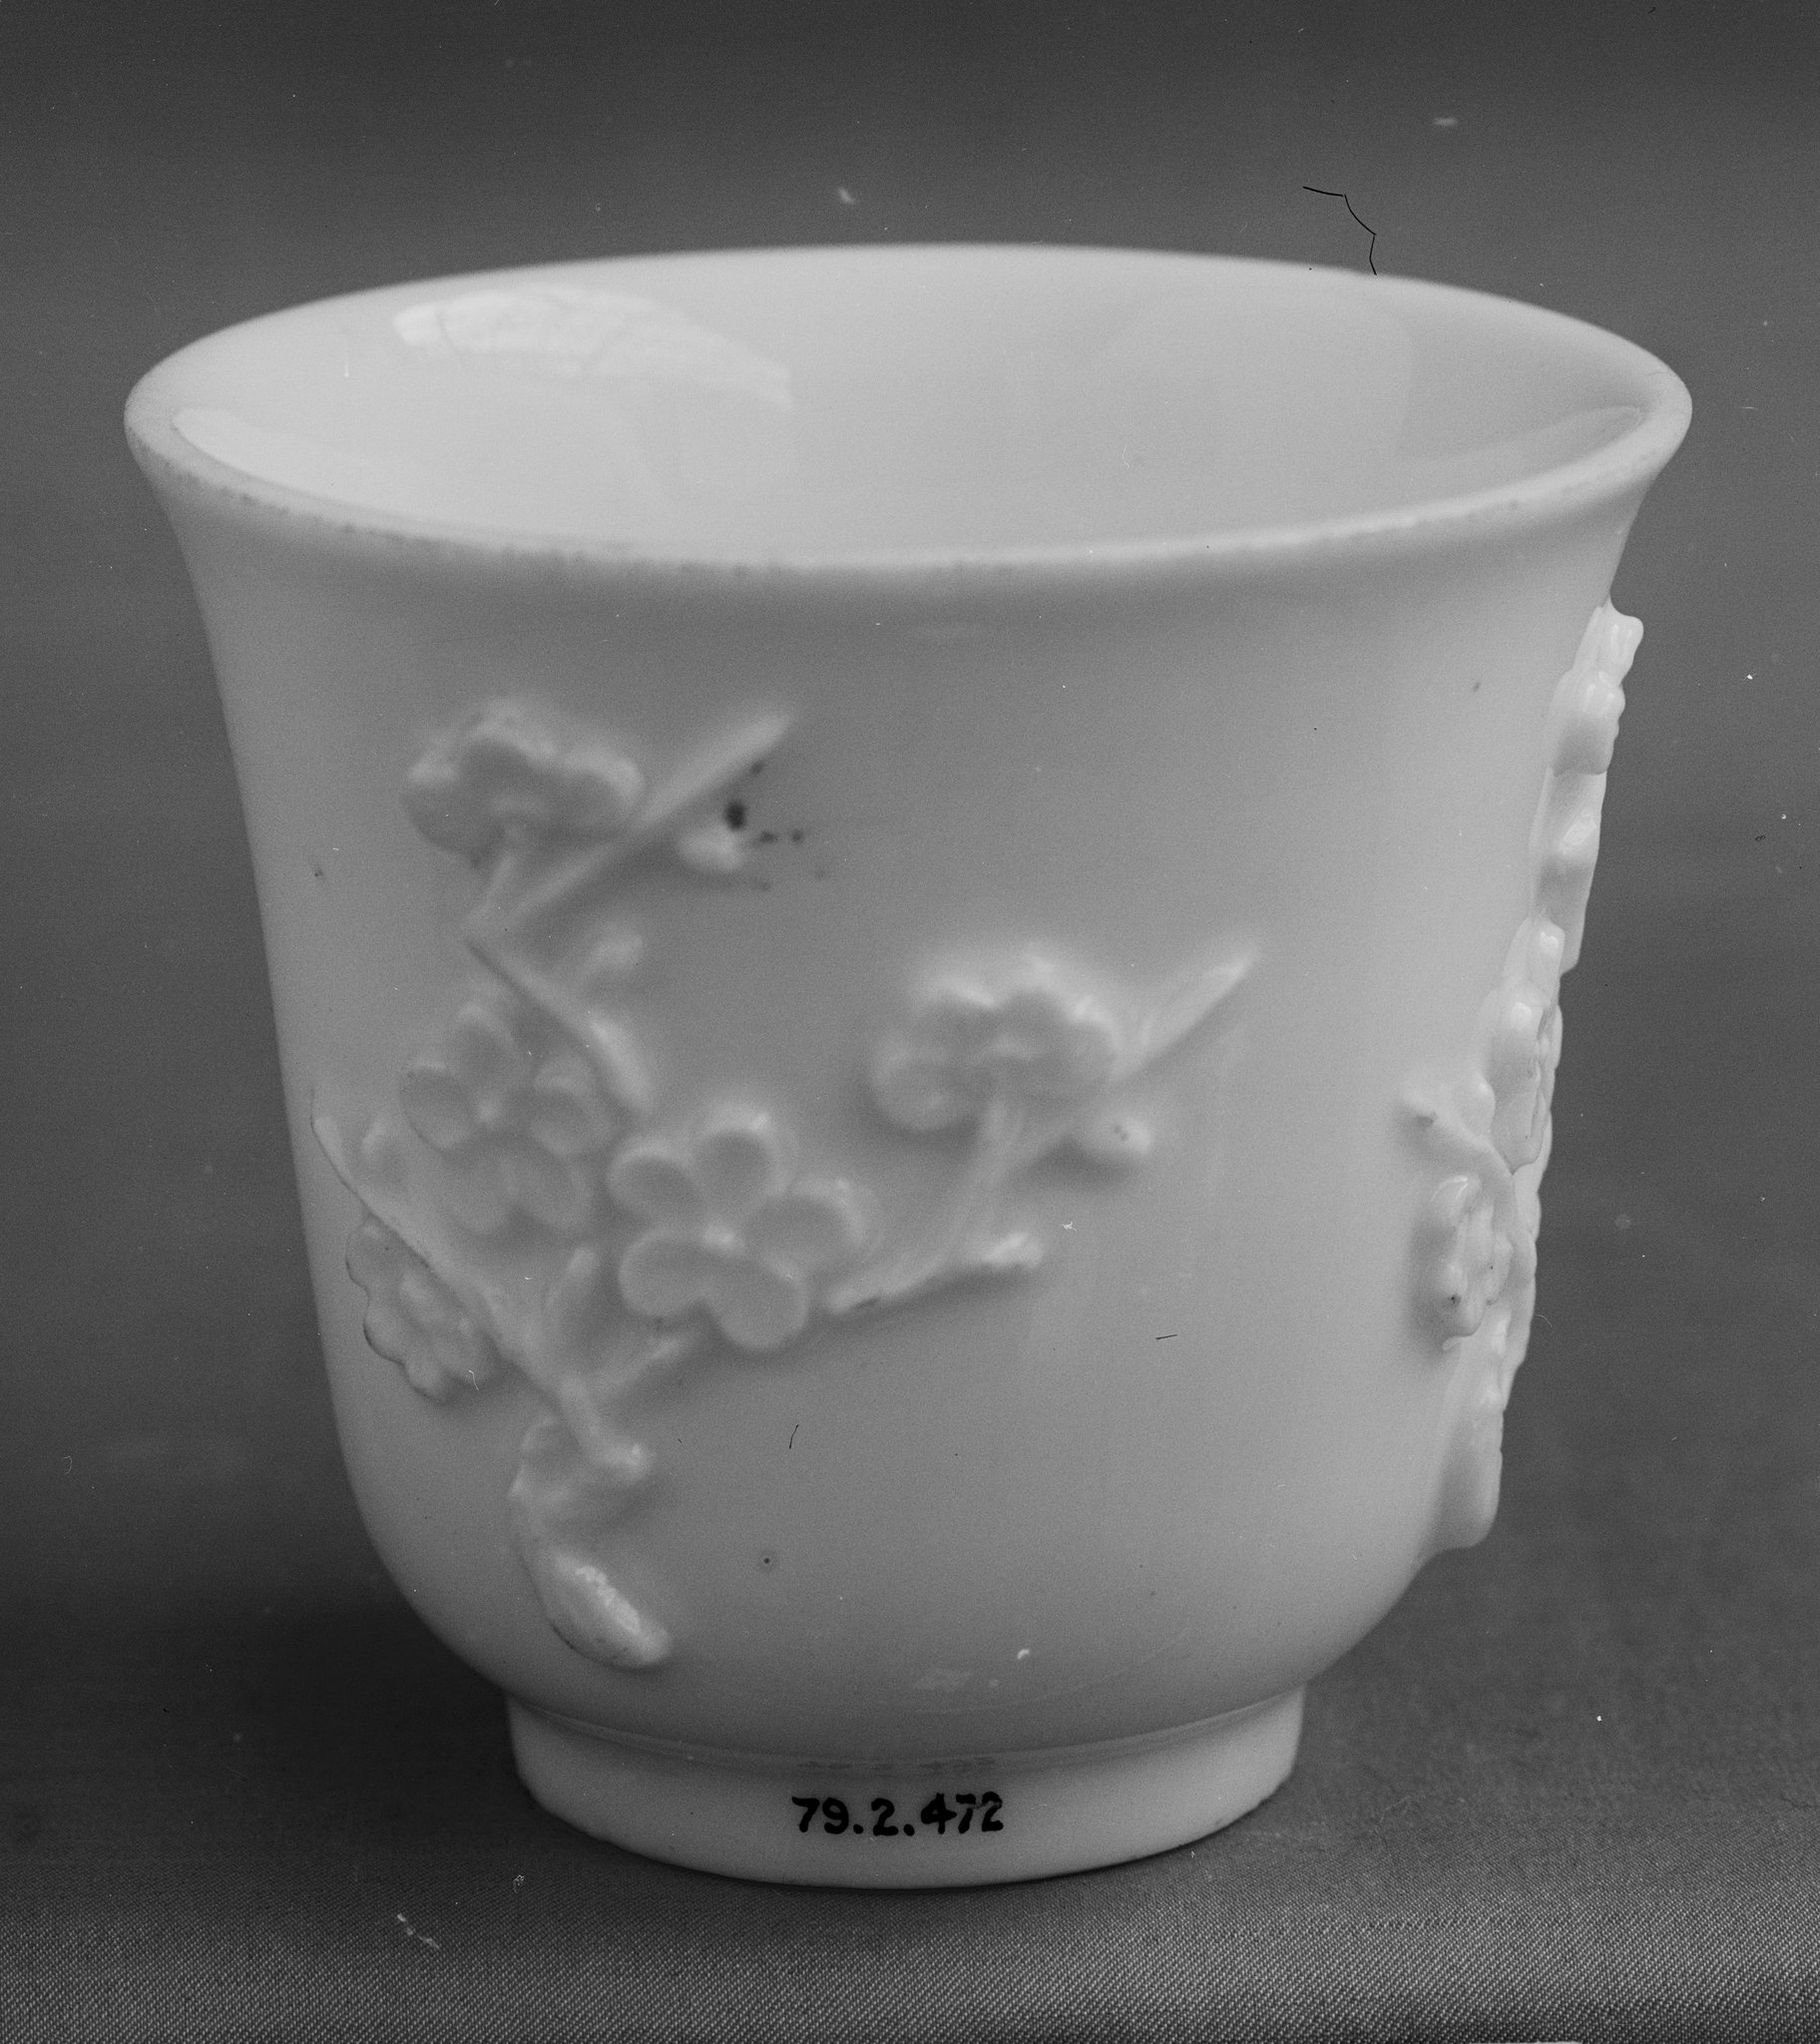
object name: cup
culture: chinese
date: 1667-1733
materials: glaze, porcelain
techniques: relief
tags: flowers